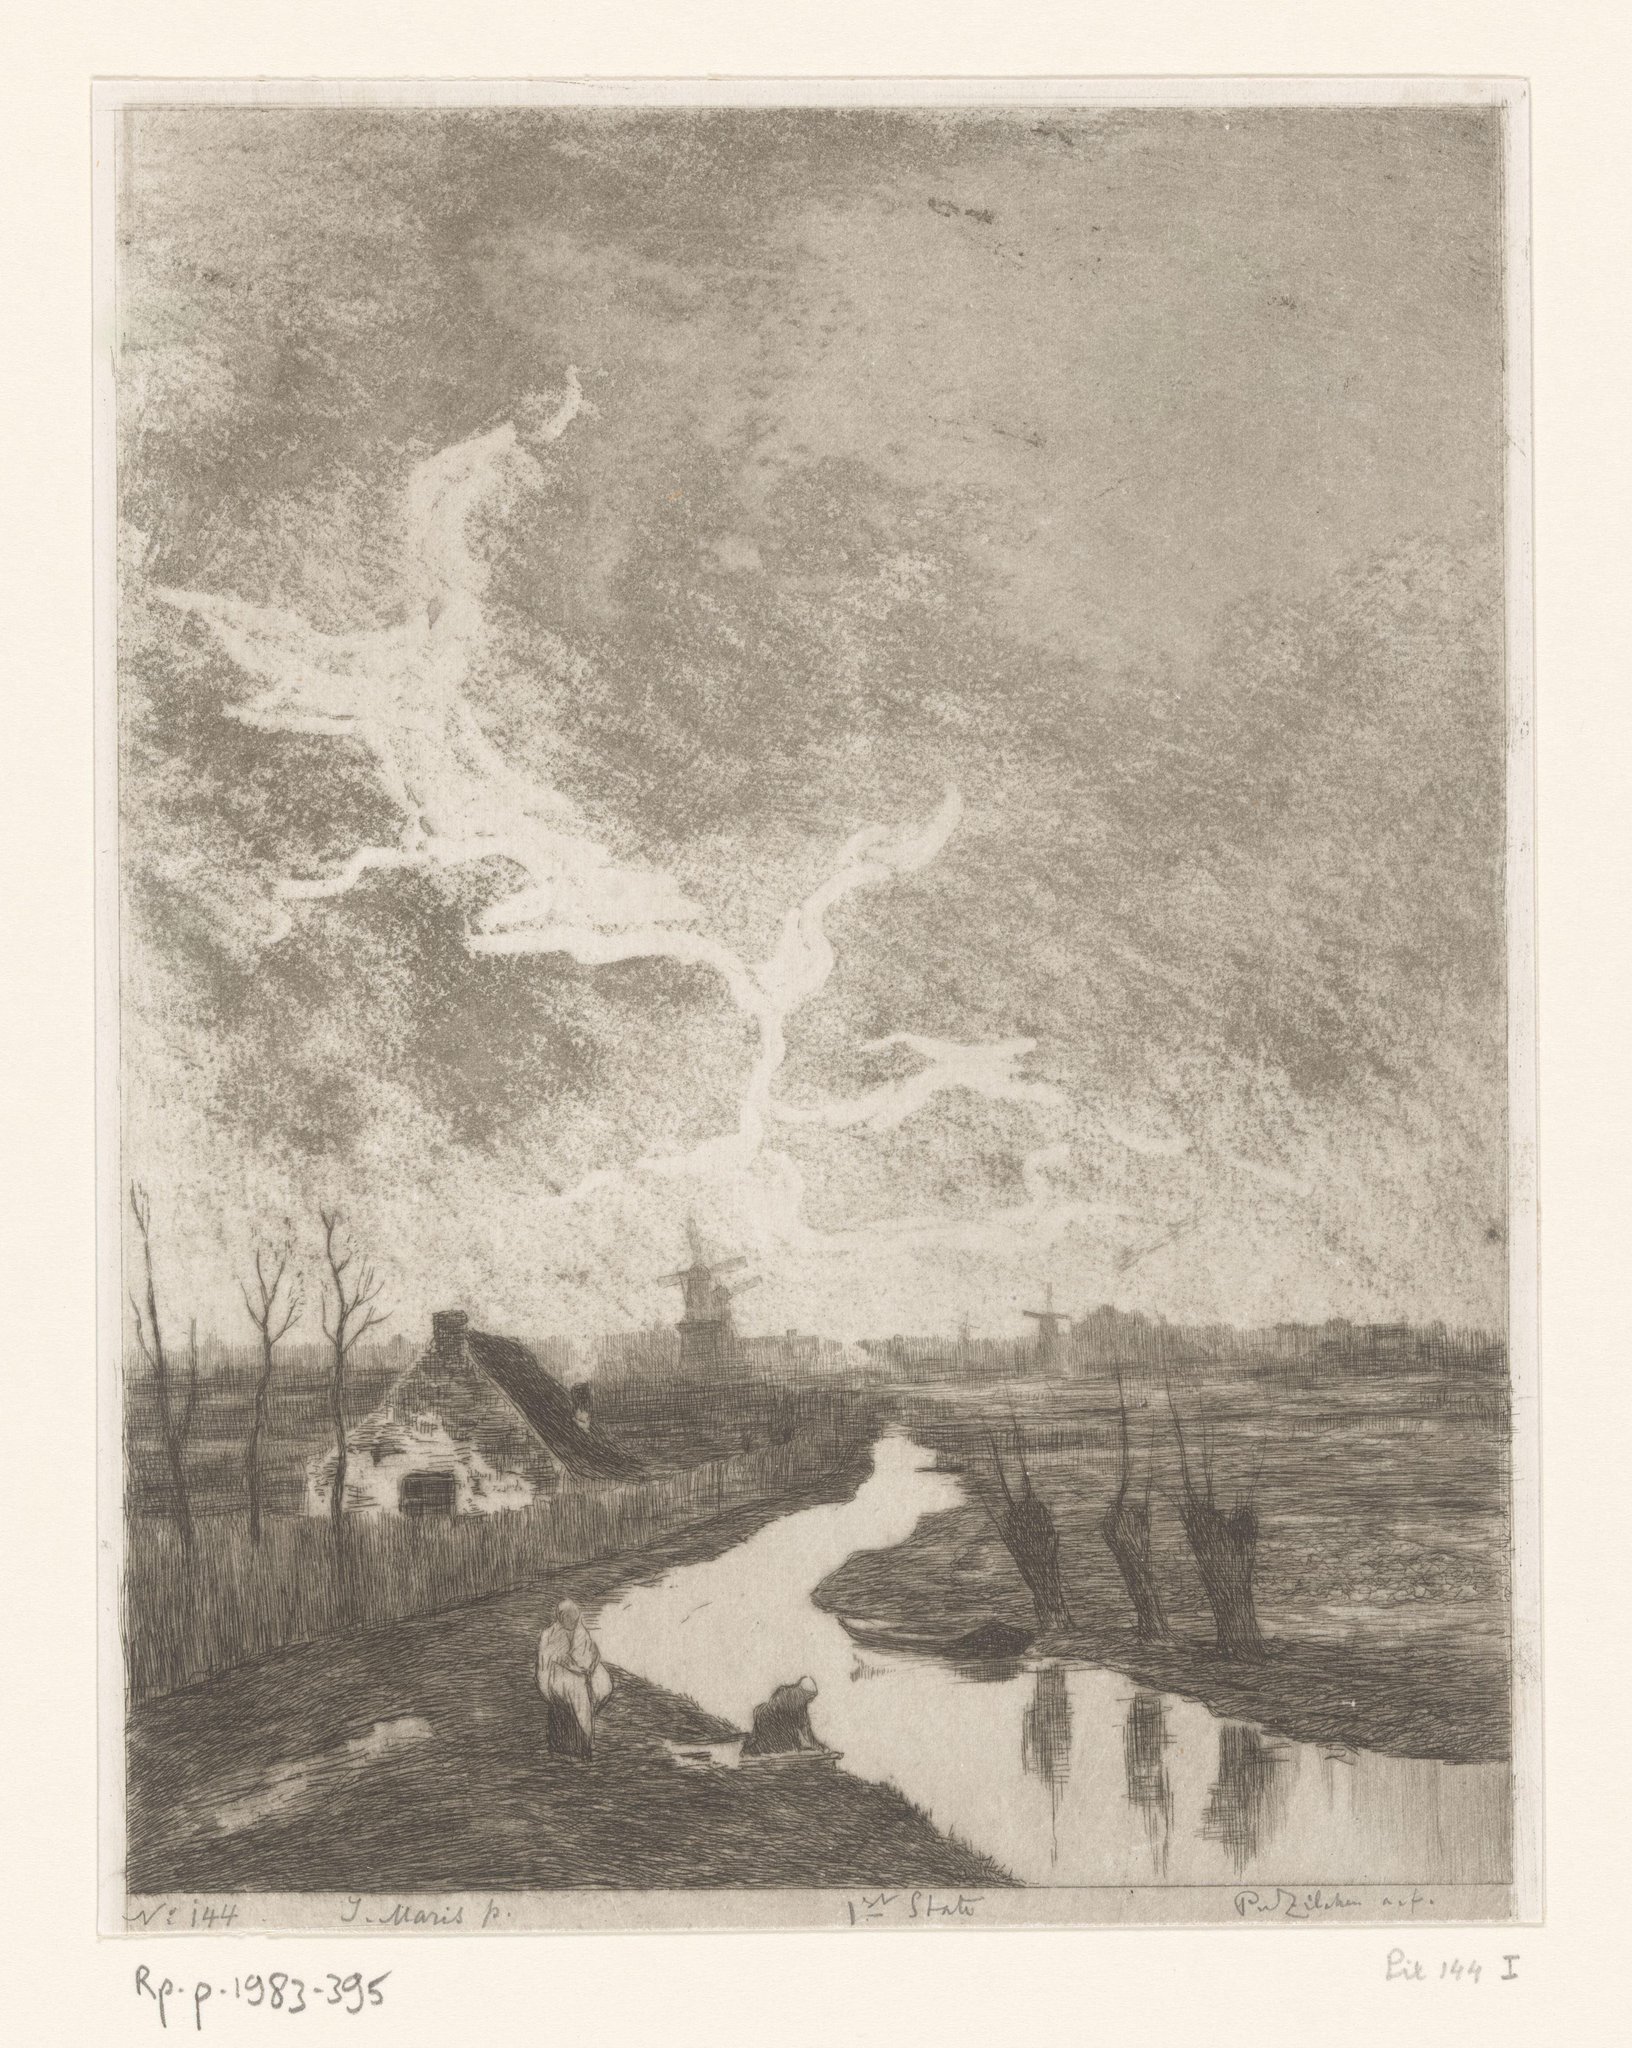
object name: print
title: Weidelandschap met sloot, boerderij en molens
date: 1867-1890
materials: paper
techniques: aquatint, drypoint, etching, intaglio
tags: windmill in landscape, small canal, ditch, farm or solitary house in landscape, the hague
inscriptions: collector's mark: Lugt 2228